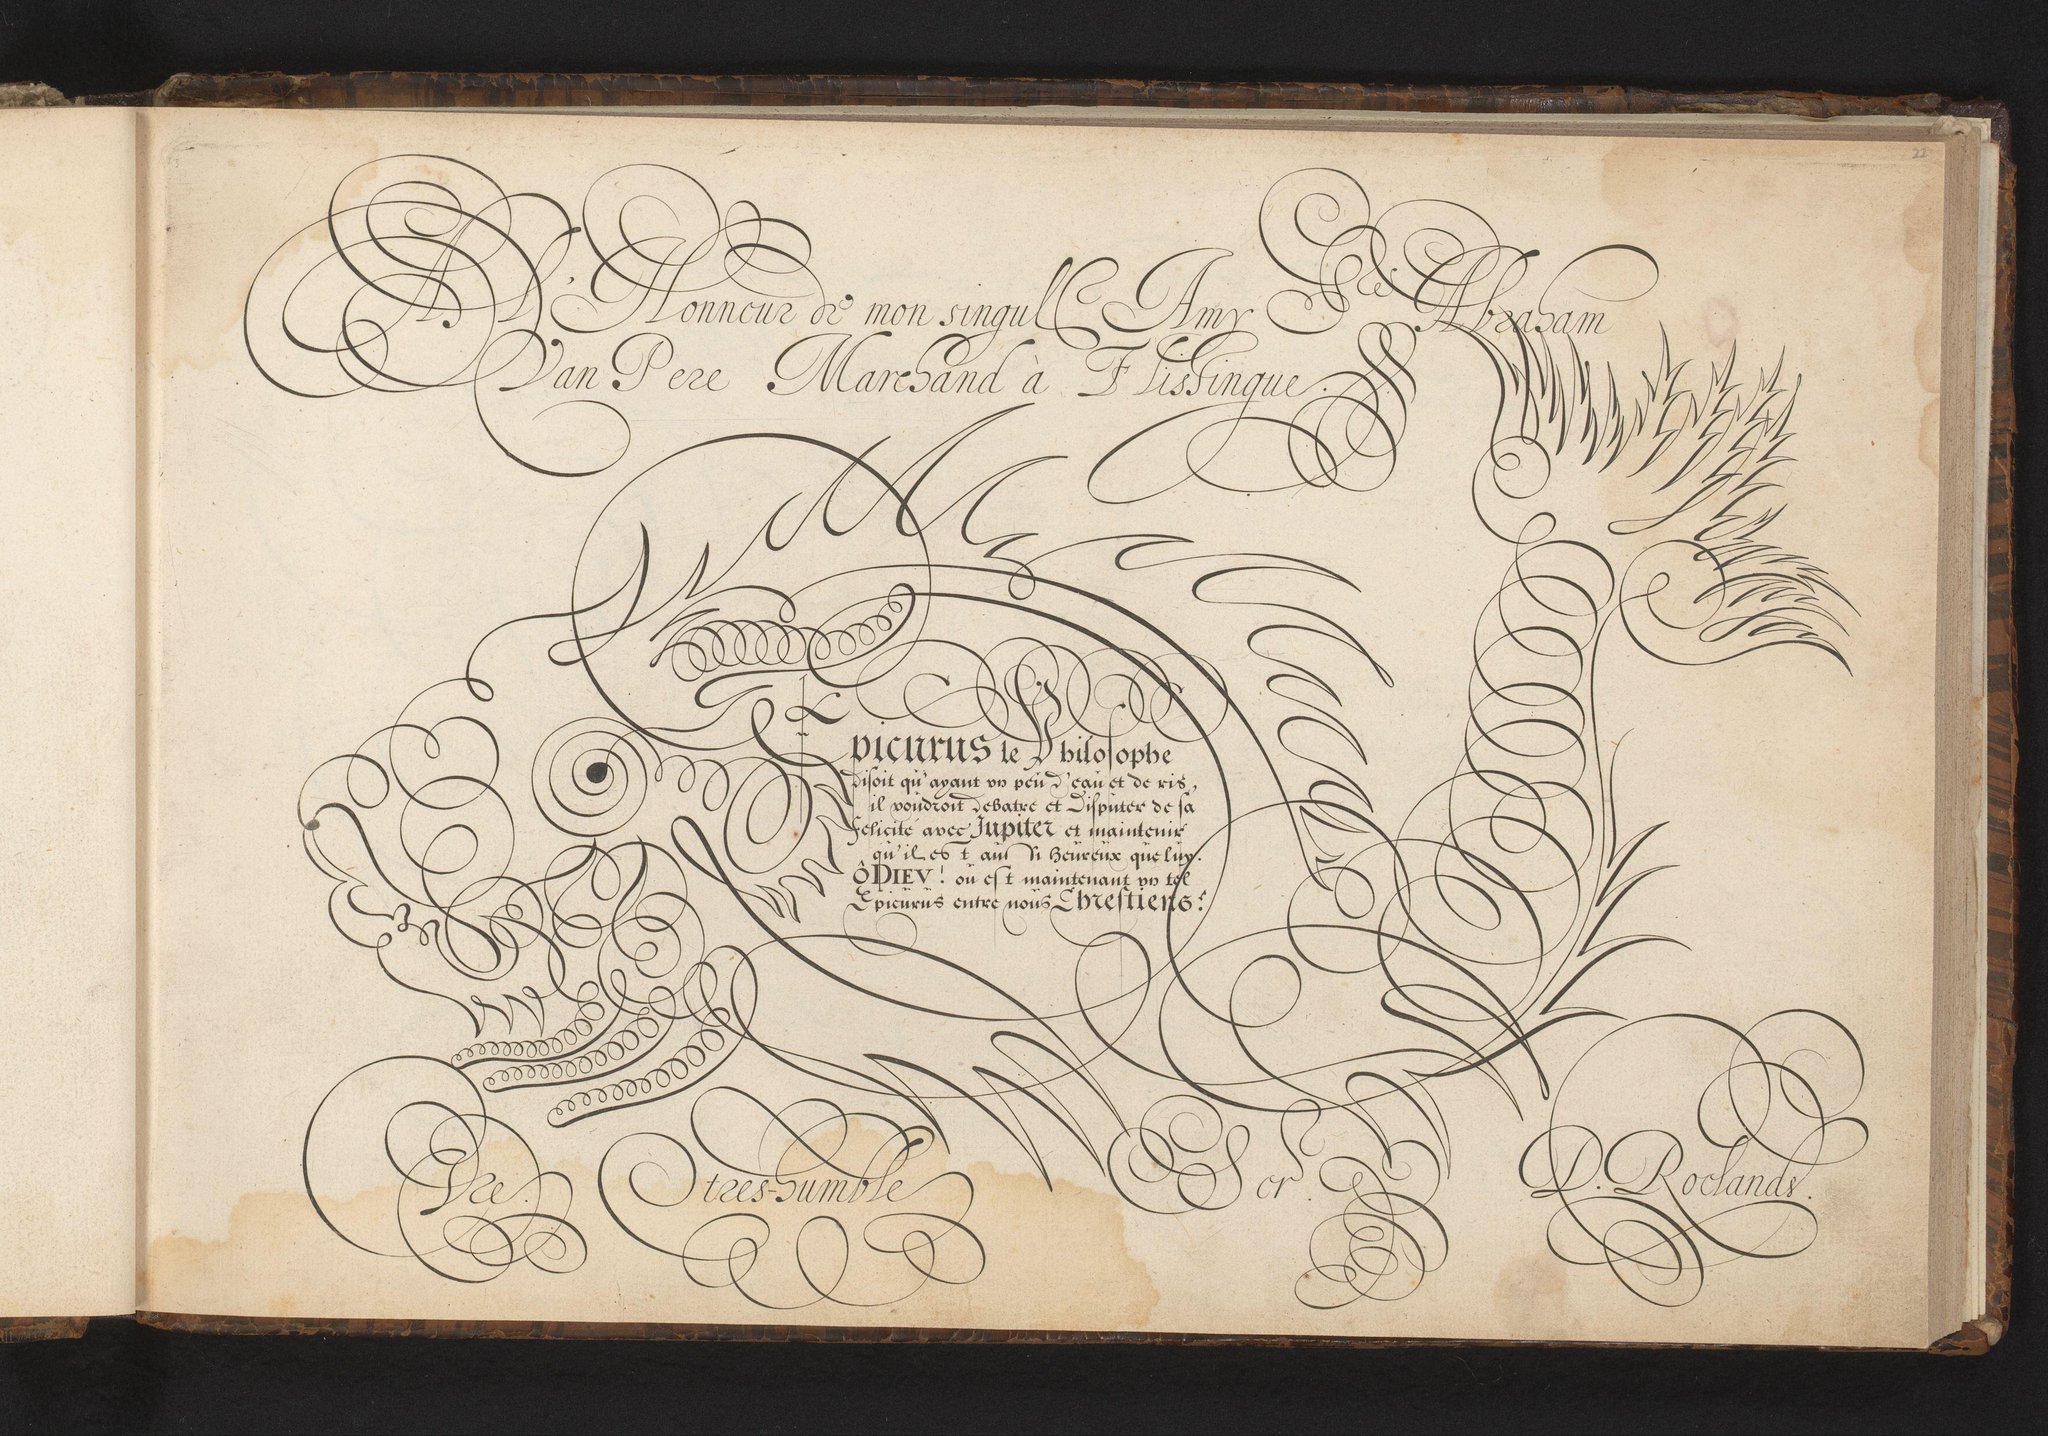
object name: ornament print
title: 't Magazin oft pac-huys der loffelycker penn-const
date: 1616-1617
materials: paper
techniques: engraving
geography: flushing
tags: calligraphy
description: Schrijfvoorbeeld met een grote vis in krulwerk en zeven regels tekst in het Fran: Epicurus le Philosophe ... Daarboven een tweeregelige opdracht aan Abraham van Pere uit Vlissingen. De prent maakt deel uit van een album.